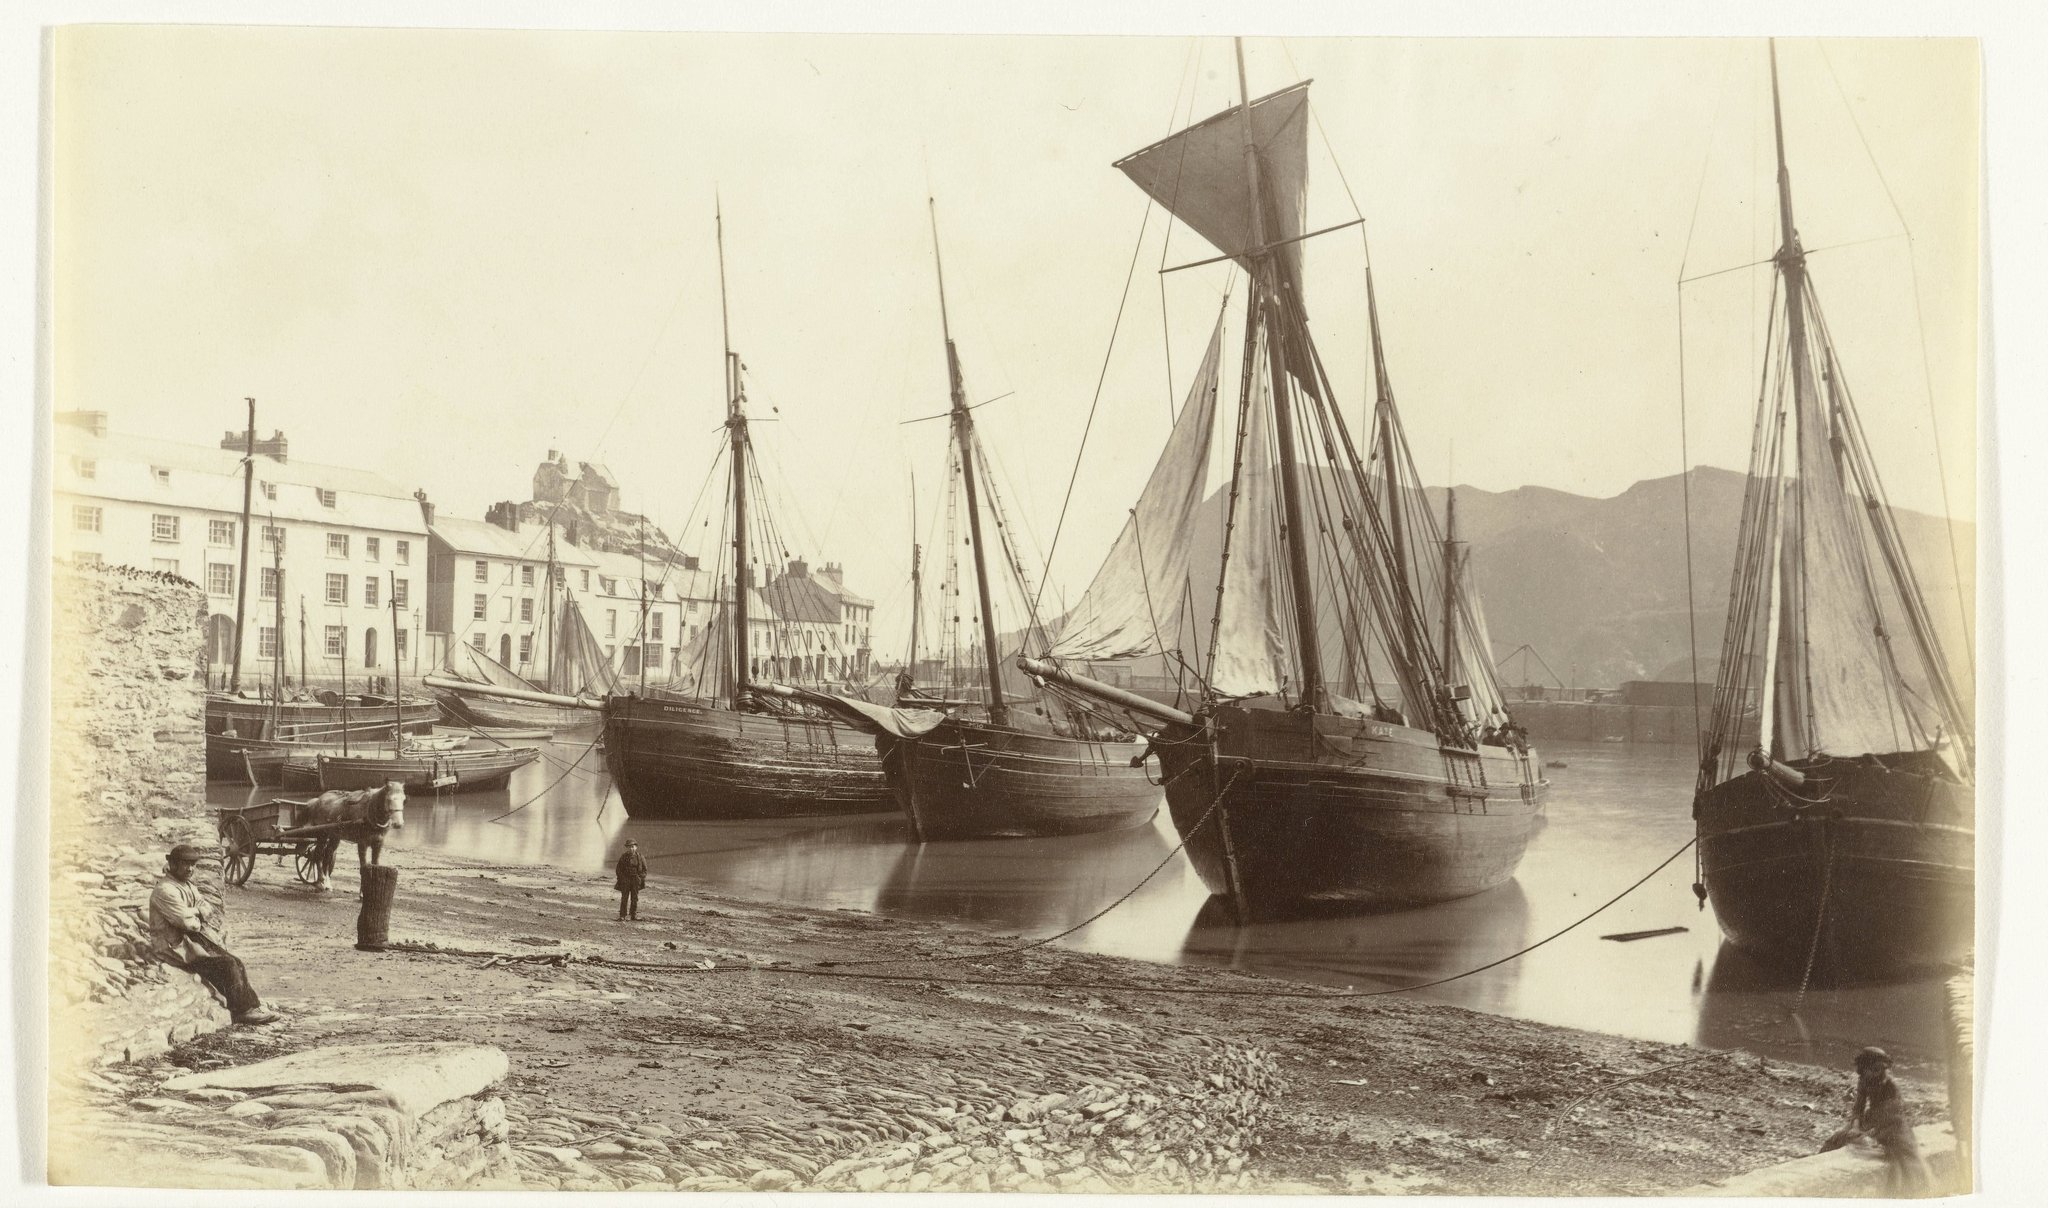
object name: photograph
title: Schepen in een haven, mogelijk Saint Peter Port in Guernsey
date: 1880-1905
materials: paper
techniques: albumen print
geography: guernsey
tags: harbour